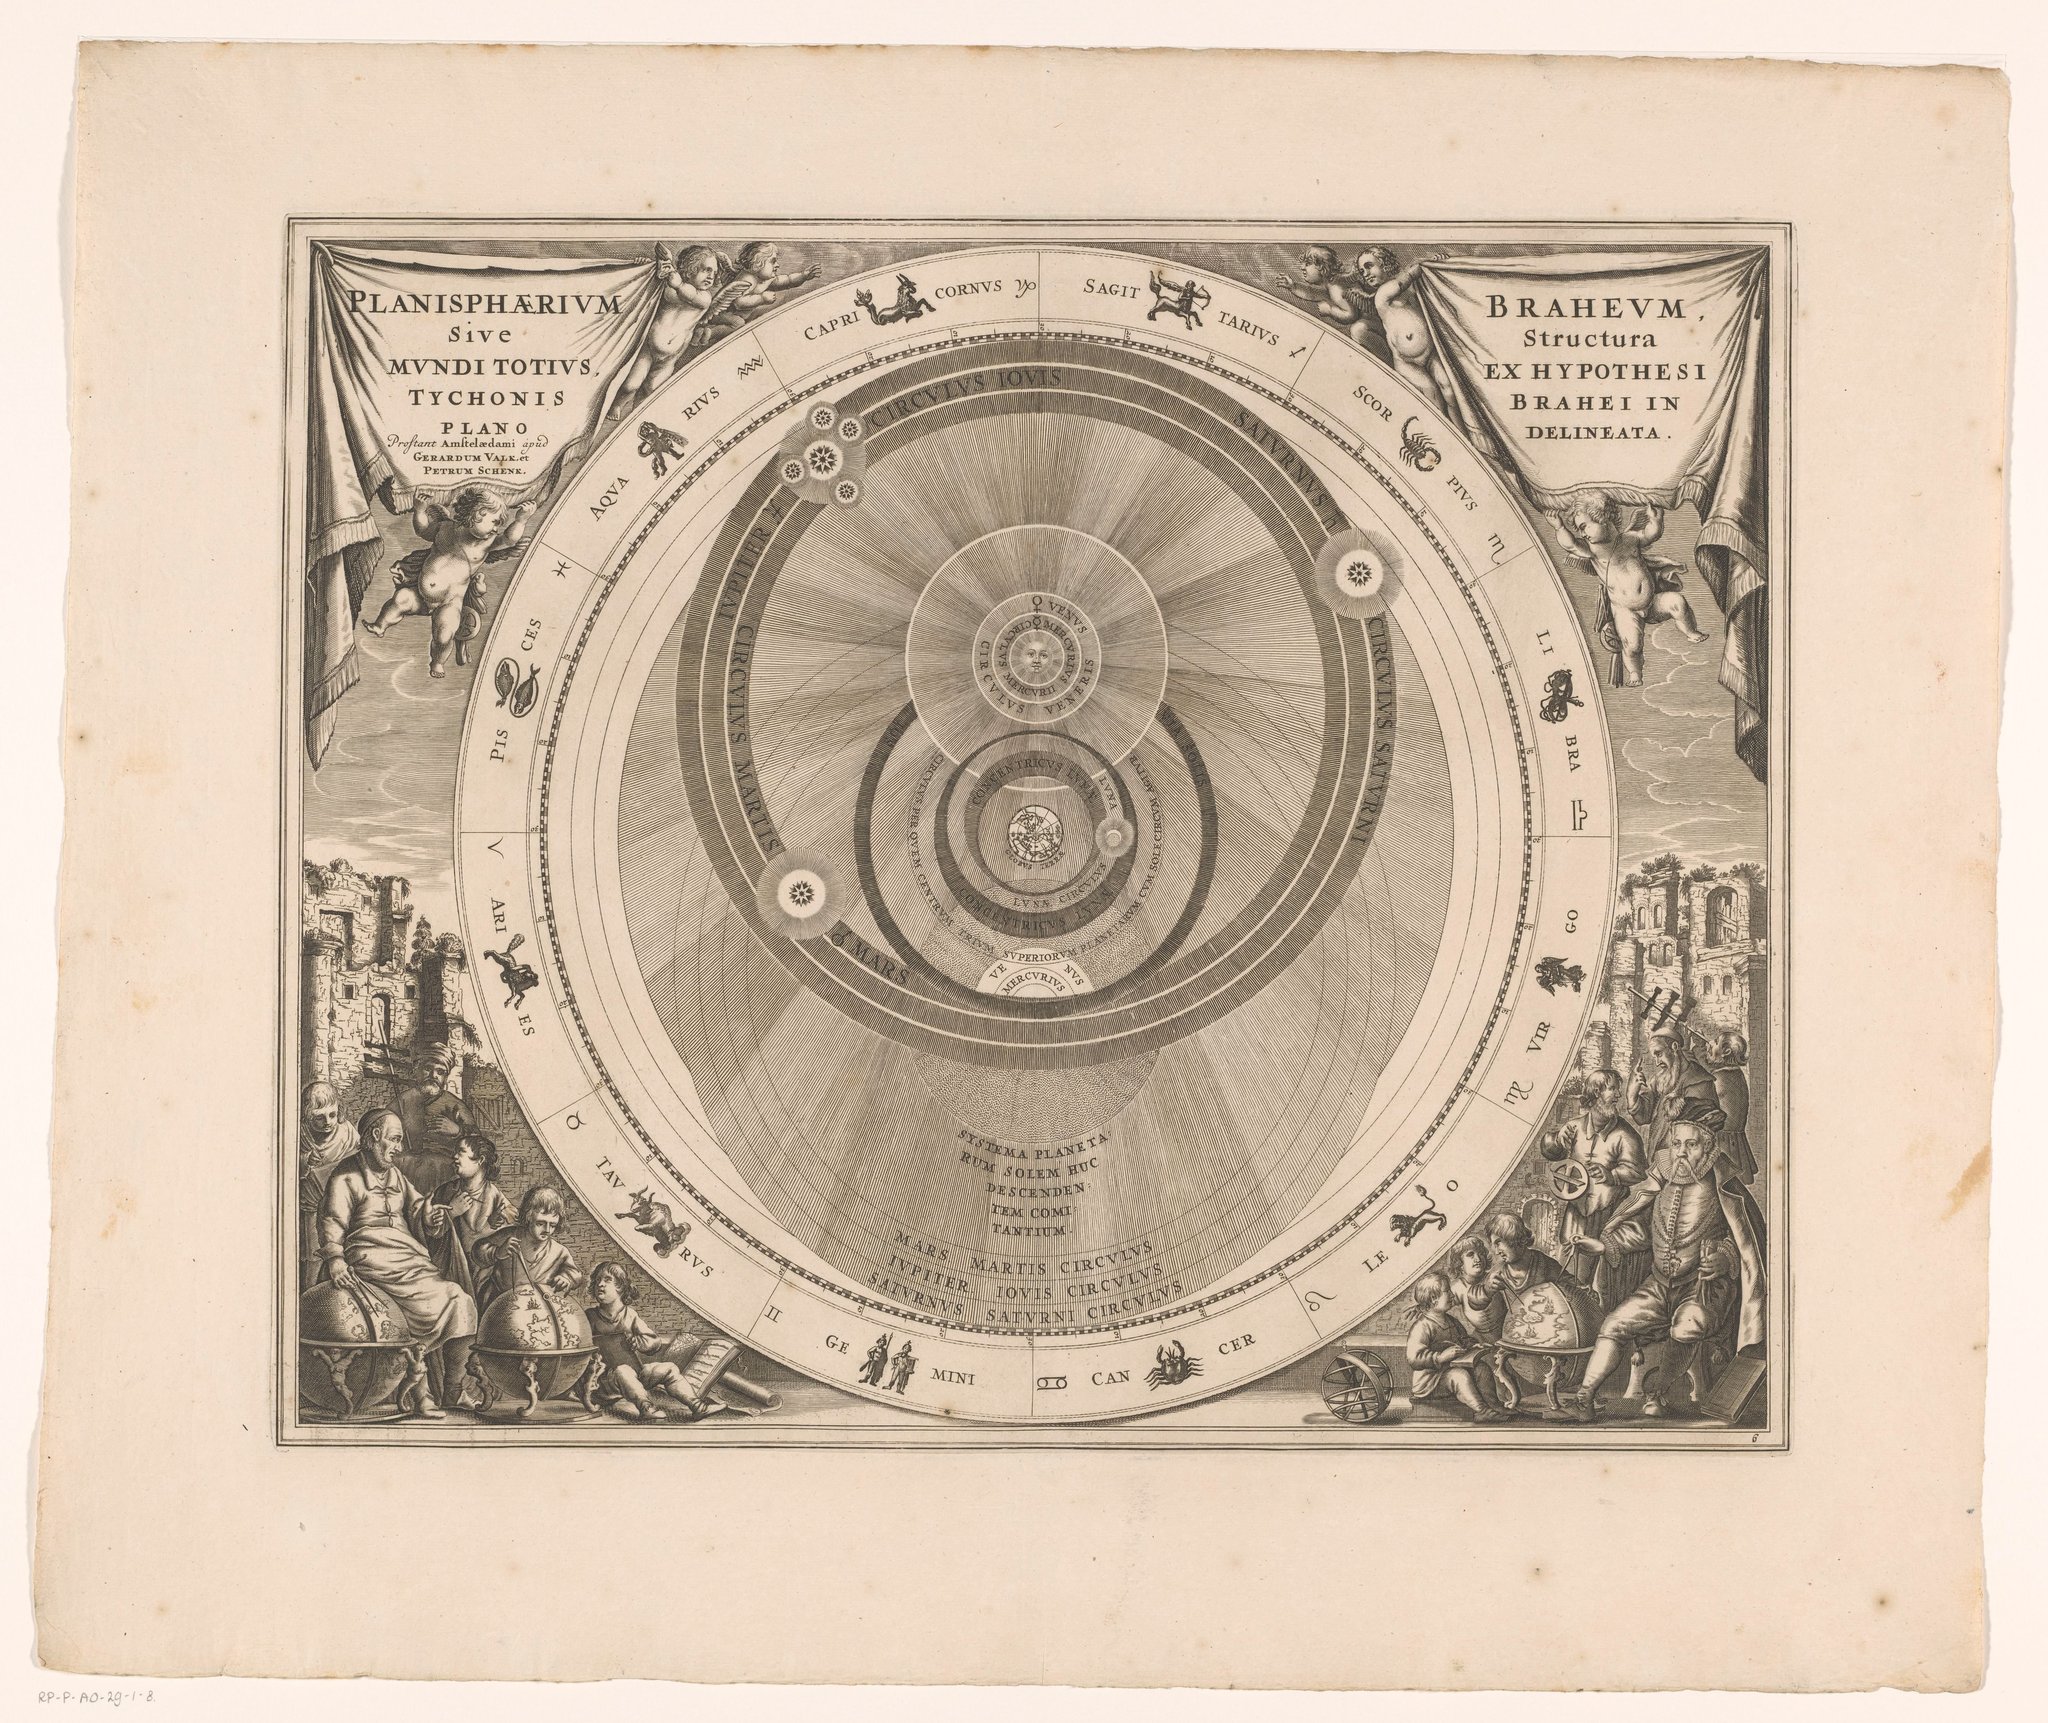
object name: map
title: Planisphaerium Braheum sive structura mundi totius ex hypothesi Tychonis (...)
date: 1660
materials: paper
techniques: engraving, etching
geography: amsterdam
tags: zodiac; the twelve zodiacal signs together, star-chart, star map, planets; planetary system, solar system, instruments used in geodesy, surveying instruments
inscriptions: collector's mark: Lugt 2228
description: Hemelkaart waar het geocentrische stelsel van Tycho Brahe op te zien is. In het midden de aarde, met daaromheen de banen van de zon en de maan. Om de zon de banen van de planeten. In de buitenste ring de dierenriem. Links- en rechtsboven de titelcartouches, gedragen door putti. Rechtsonder is Tycho Brahe, te herkennen aan zijn snor, zittend afgebeeld. Rechtsonder genummerd: 6.